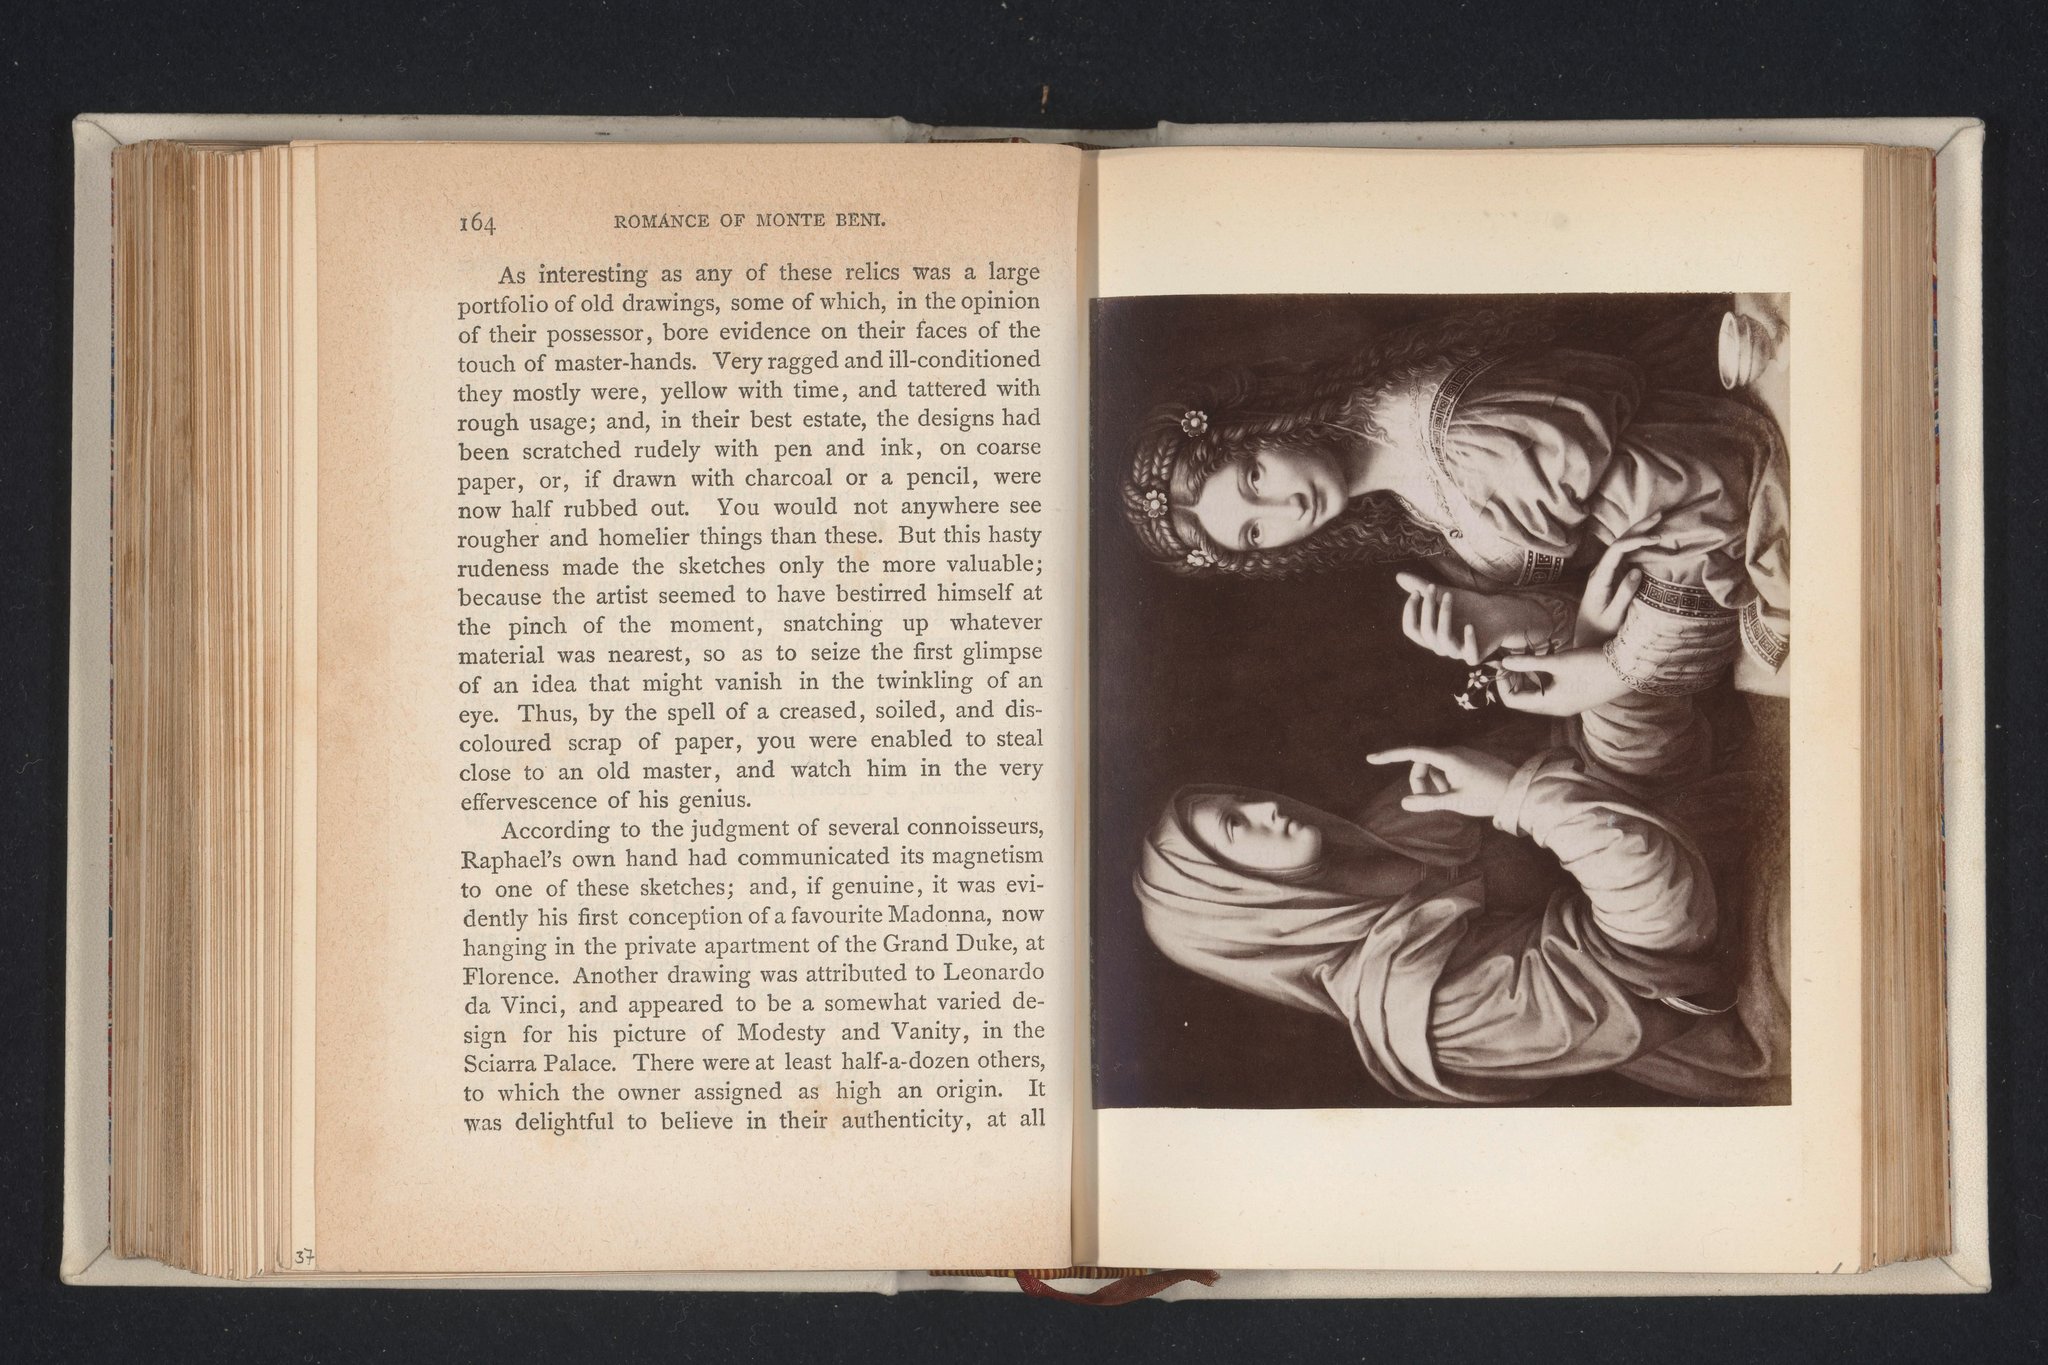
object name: page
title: Fotoreproductie van een tekening naar Modestia et Vanitas door Leonardo da Vinci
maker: Anonymous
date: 1850-1860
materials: photographic support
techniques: albumen print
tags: drawing